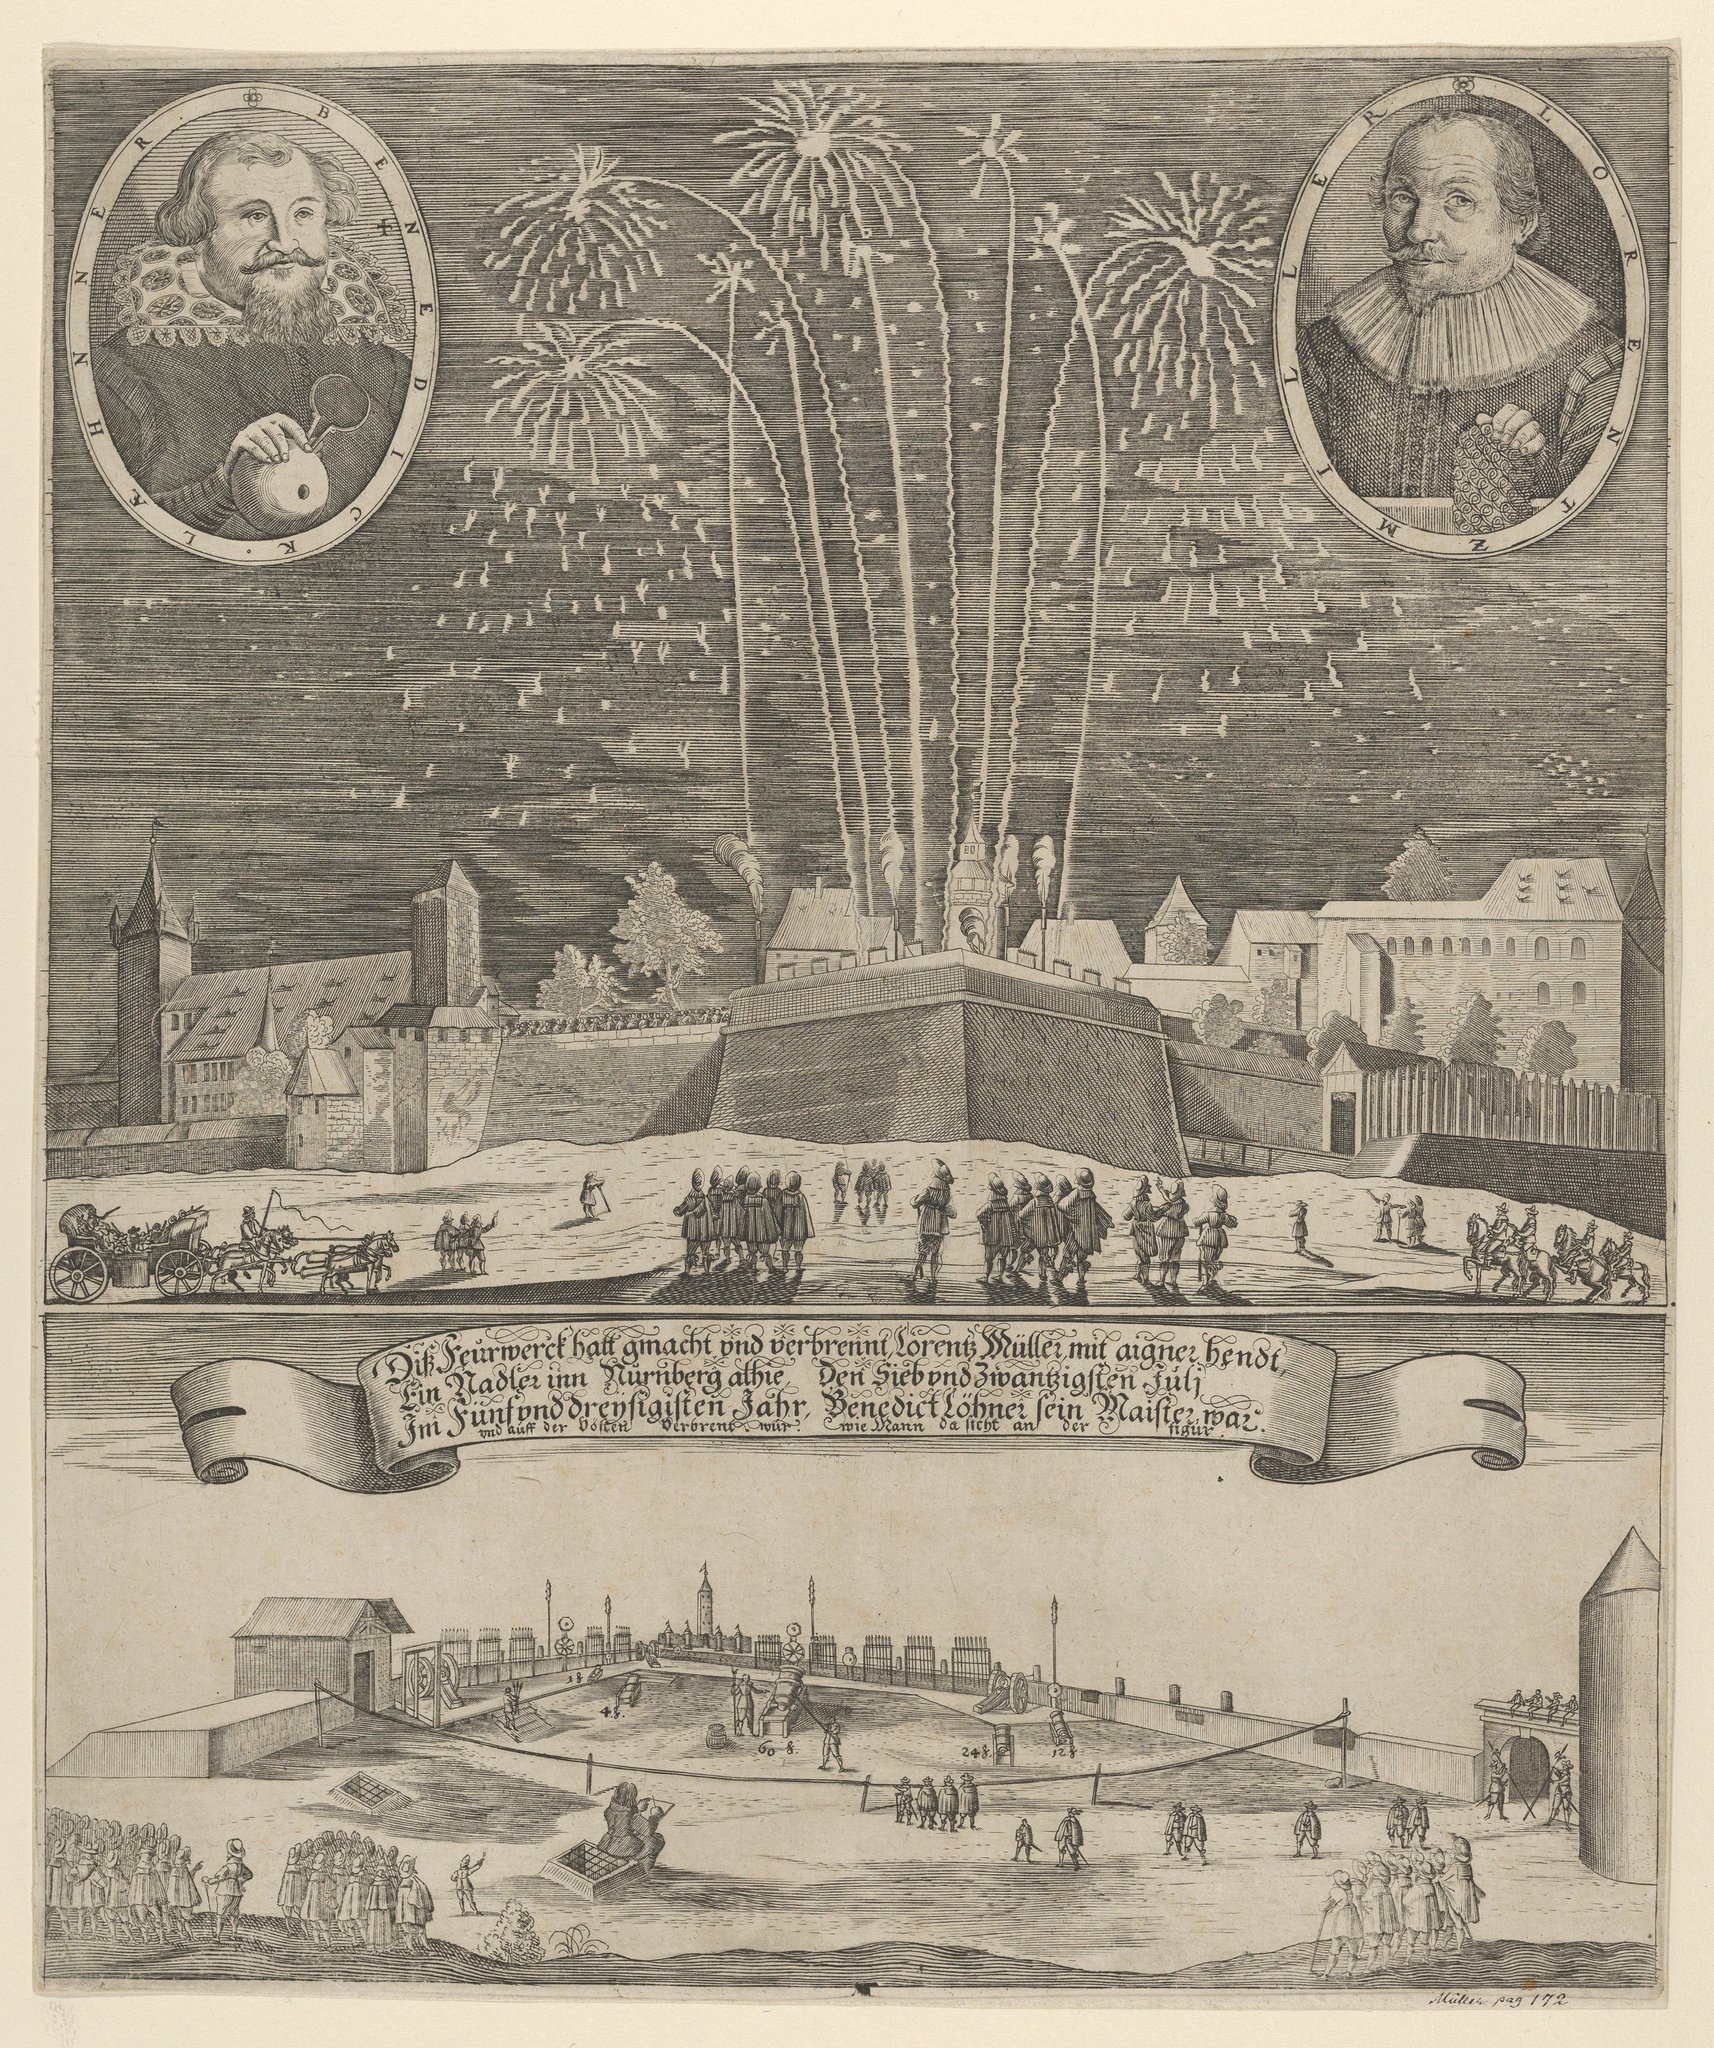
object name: print, fete, ornament architecture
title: Fireworks display by Lorenz Müller as proof of mastership, Nuremberg 1635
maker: Anonymous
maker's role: artist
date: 1635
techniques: etching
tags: men,fireworks